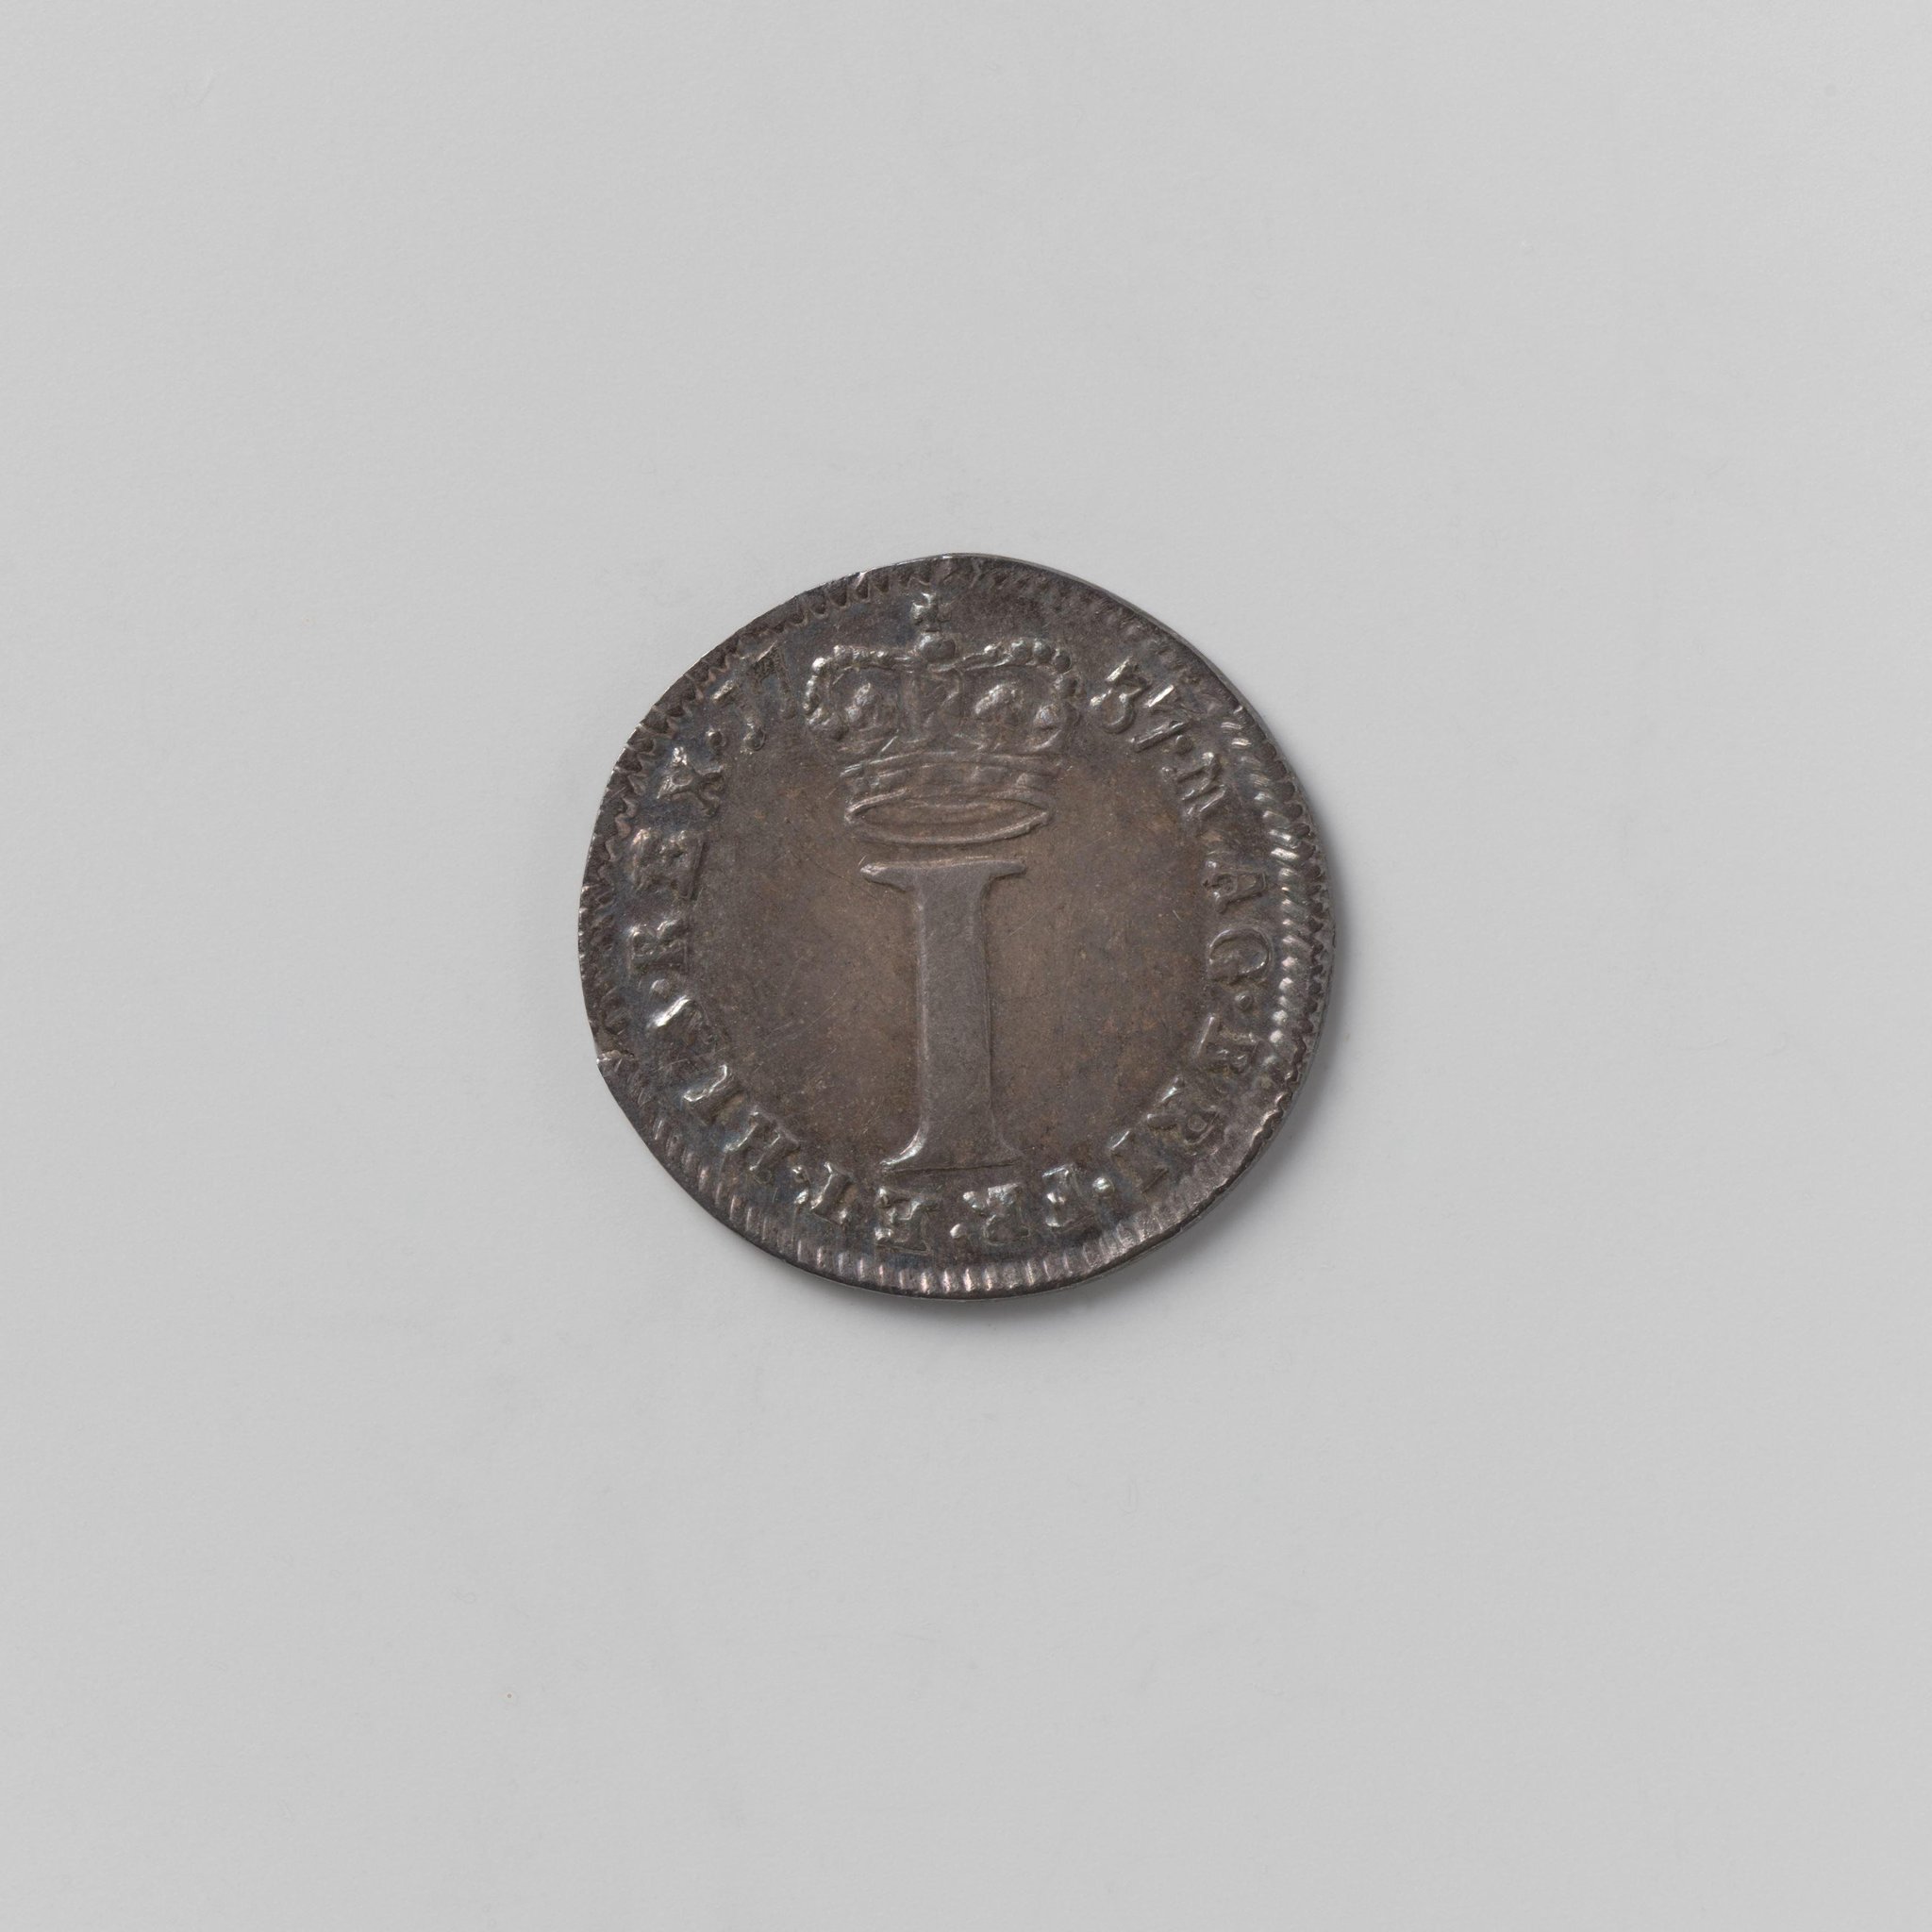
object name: coin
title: Engeland, George II, penny, 1737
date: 1737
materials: silver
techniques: striking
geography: london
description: Zilveren munt. Voorzijde: gelauwerd borstbeeld van de koning naar links. Keerzijde: gekroond cijfer een. Jaartal bovenaan rondom kroon. Maundy Money.